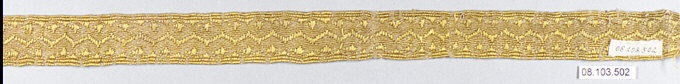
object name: galloon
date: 1701-1800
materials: cotton, silk